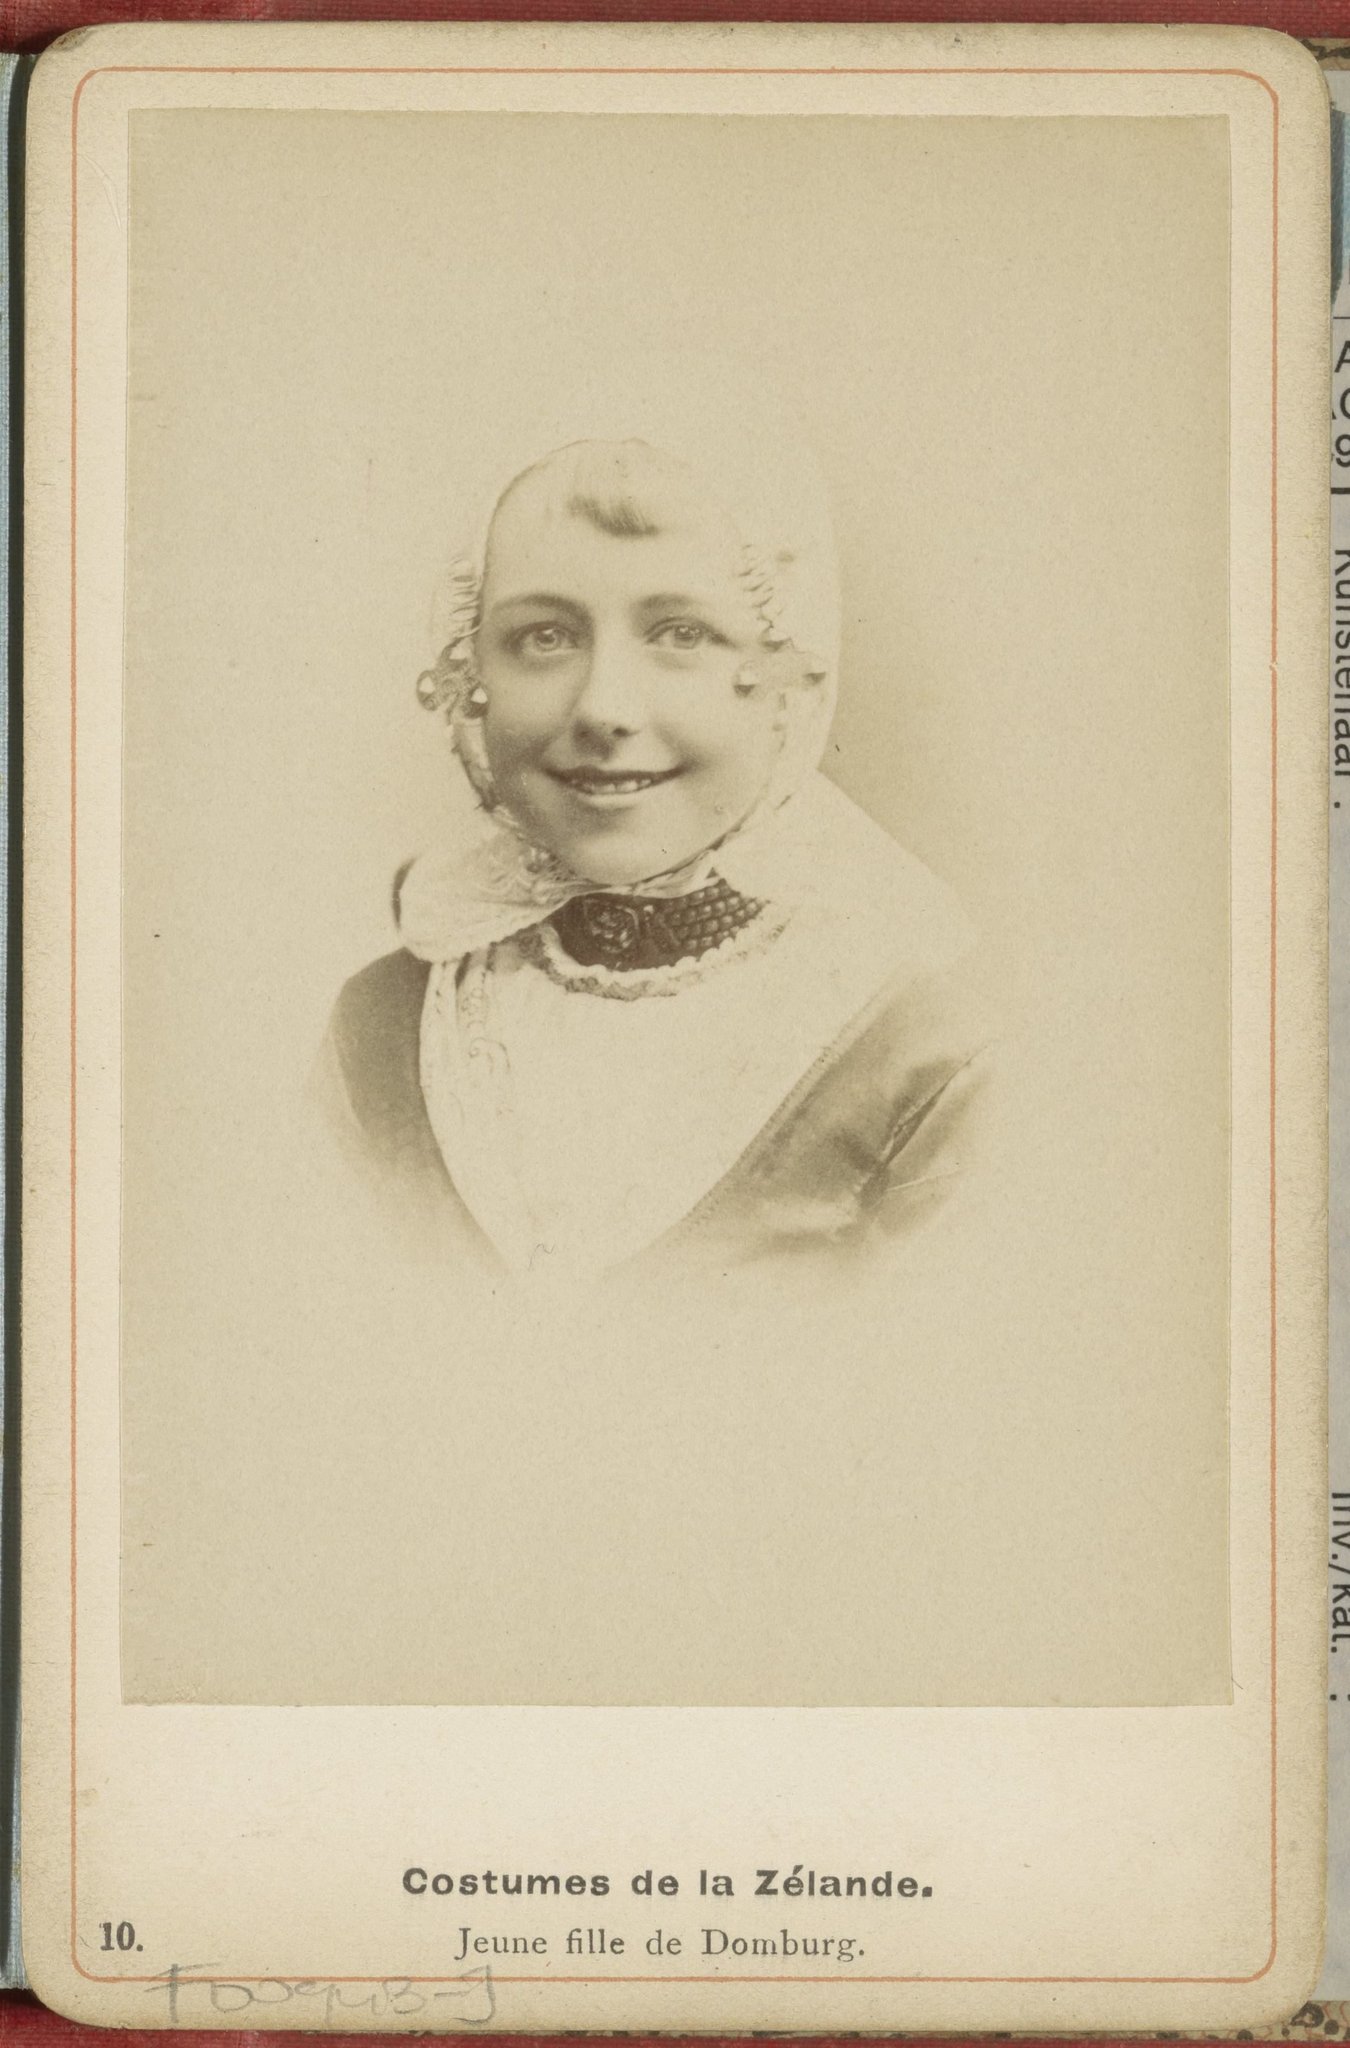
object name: photograph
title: Meisje in de klederdracht van Domburg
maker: Anonymous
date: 1870-1910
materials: cardboard, photographic support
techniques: albumen print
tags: folk costume, regional costume (+ women's clothes)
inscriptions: number: ‘10’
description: Onderdeel van Leporelloalbum met Zeeuwse klederdrachten.